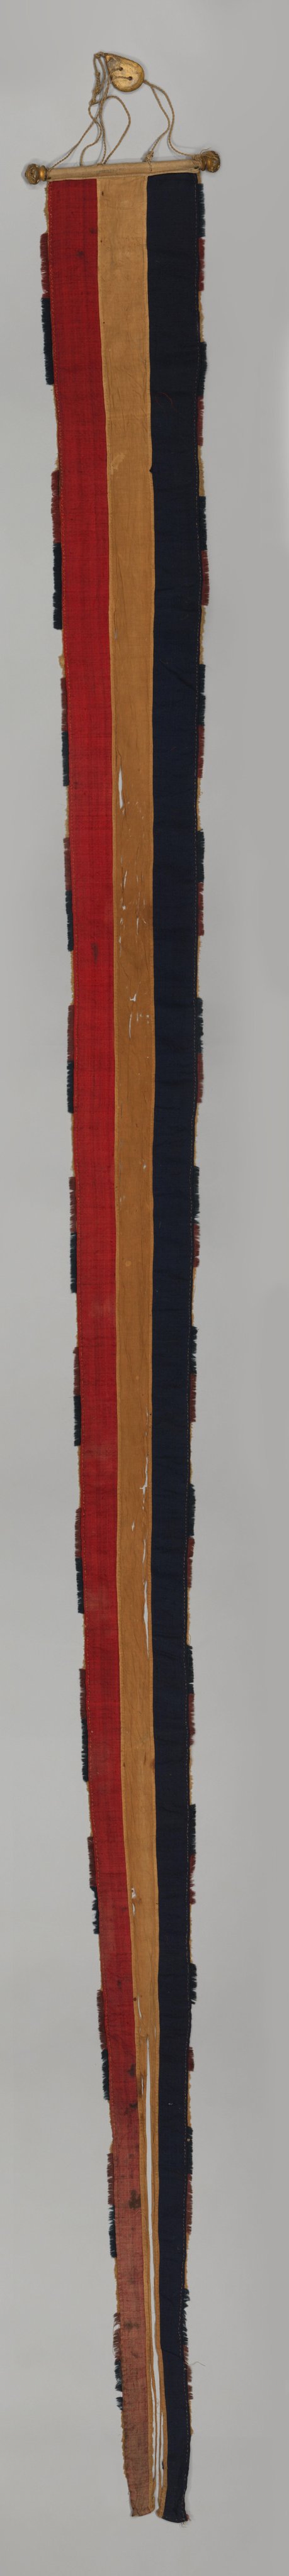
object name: pennant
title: Wimpel 'van een plezierboeier'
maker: Anonymous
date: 1700-1800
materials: cotton, wood, wool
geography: netherlands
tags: netherlands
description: Driehoekige wimpel, bestaande uit drie banen in de lengte rood-wit-blauw; aan boven- en onderzijden korte franje rood-wit-blauw. bevestigd aan een stokje waaraan twee met bladmotieven gesneden en vergulde houten knoppen. aan de stok vier gedraaide witte koorden, gaande door een hartvormige vergulde scheepsklos, waaraan een bevestigingstouw. Aan weerszijden langs de lange kanten rood-wit-blauwe korte franje. Ingescheurd.